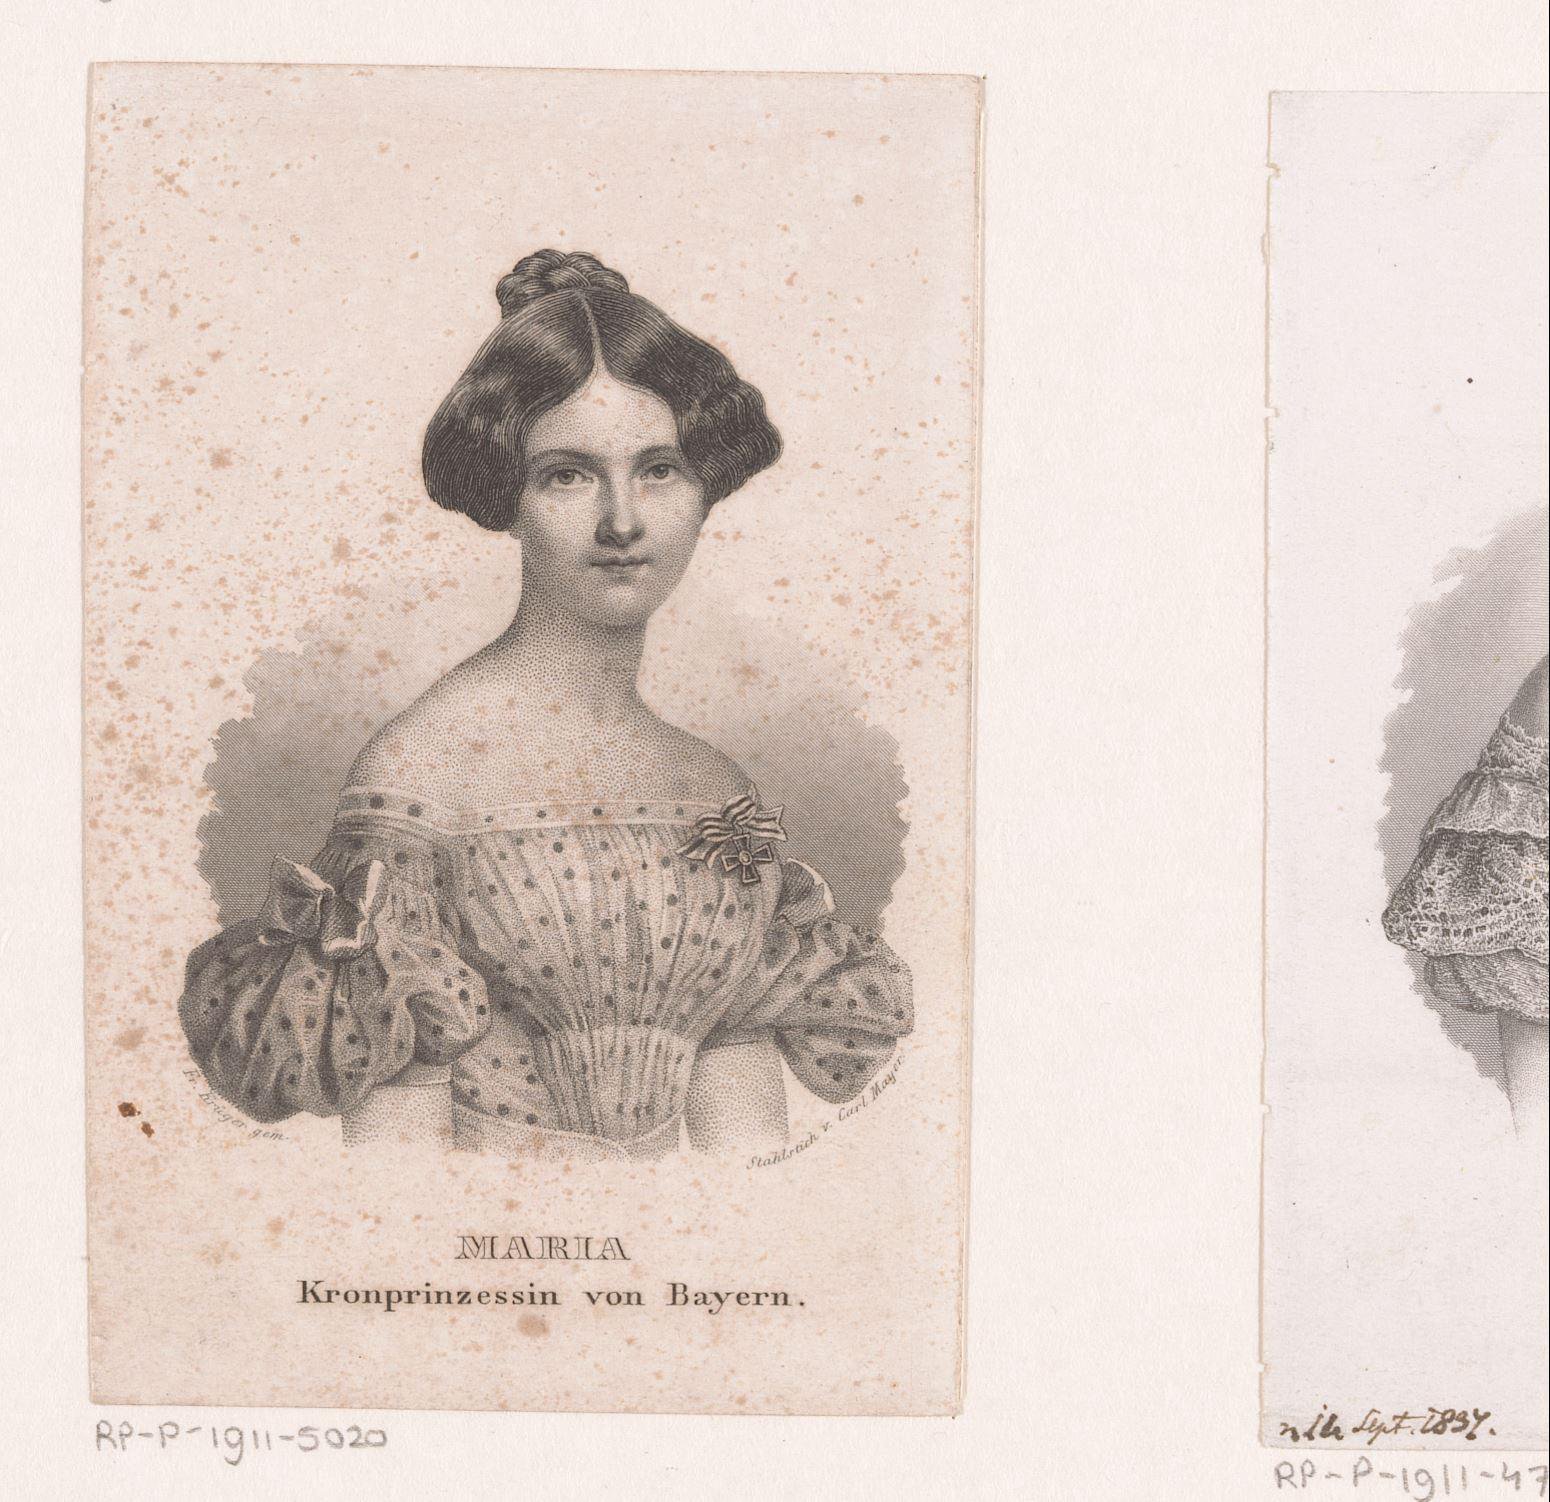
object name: print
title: Portret van Marie van Pruisen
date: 1825-1868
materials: paper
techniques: engraving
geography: nuremberg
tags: berlin, historical persons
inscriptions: collector's mark: Lugt 2228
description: Prent mogelijk afkomstig uit de Almanach de Gotha.